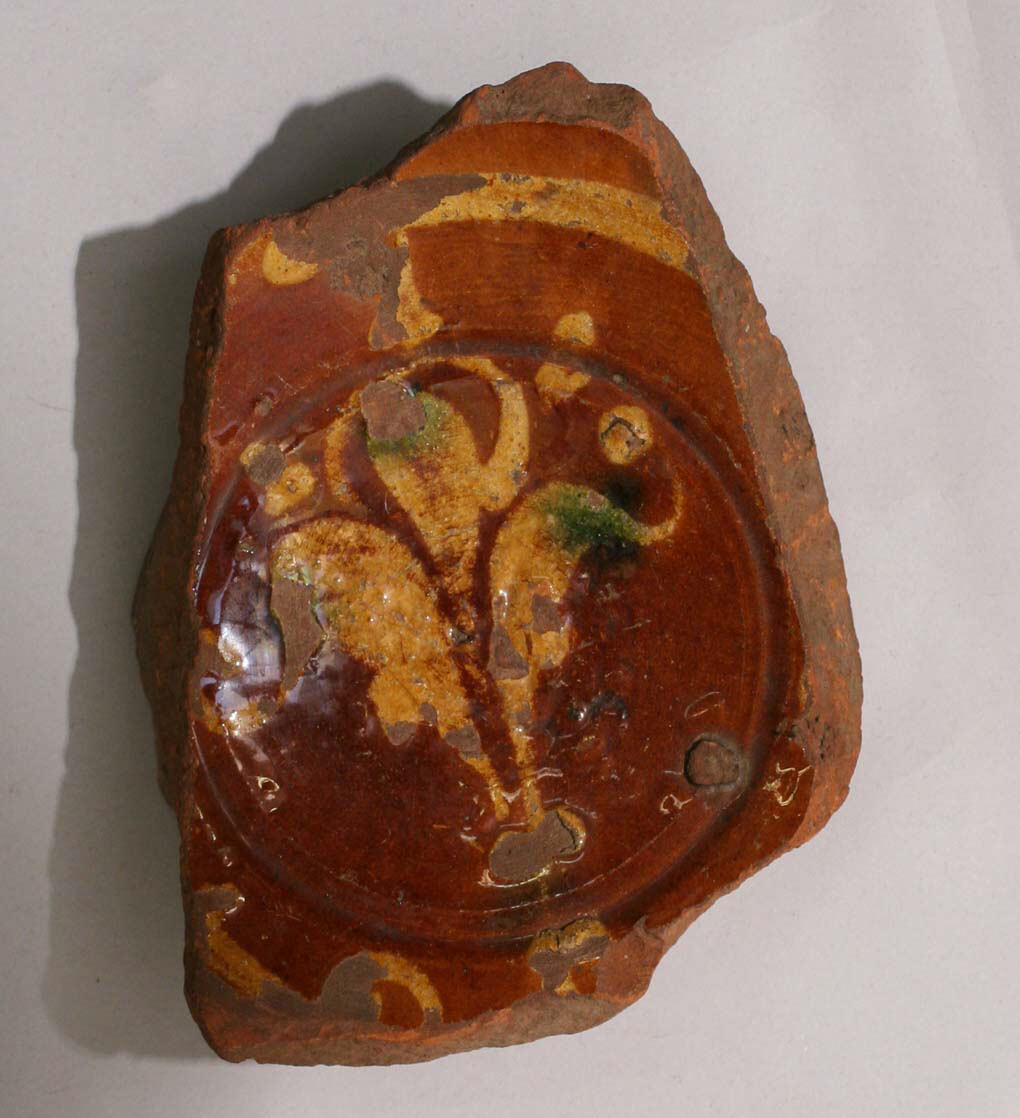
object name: ceramic fragment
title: Fragment of a Bowl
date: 1301-1500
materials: earthenware, glaze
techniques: coloring, incising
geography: egypt